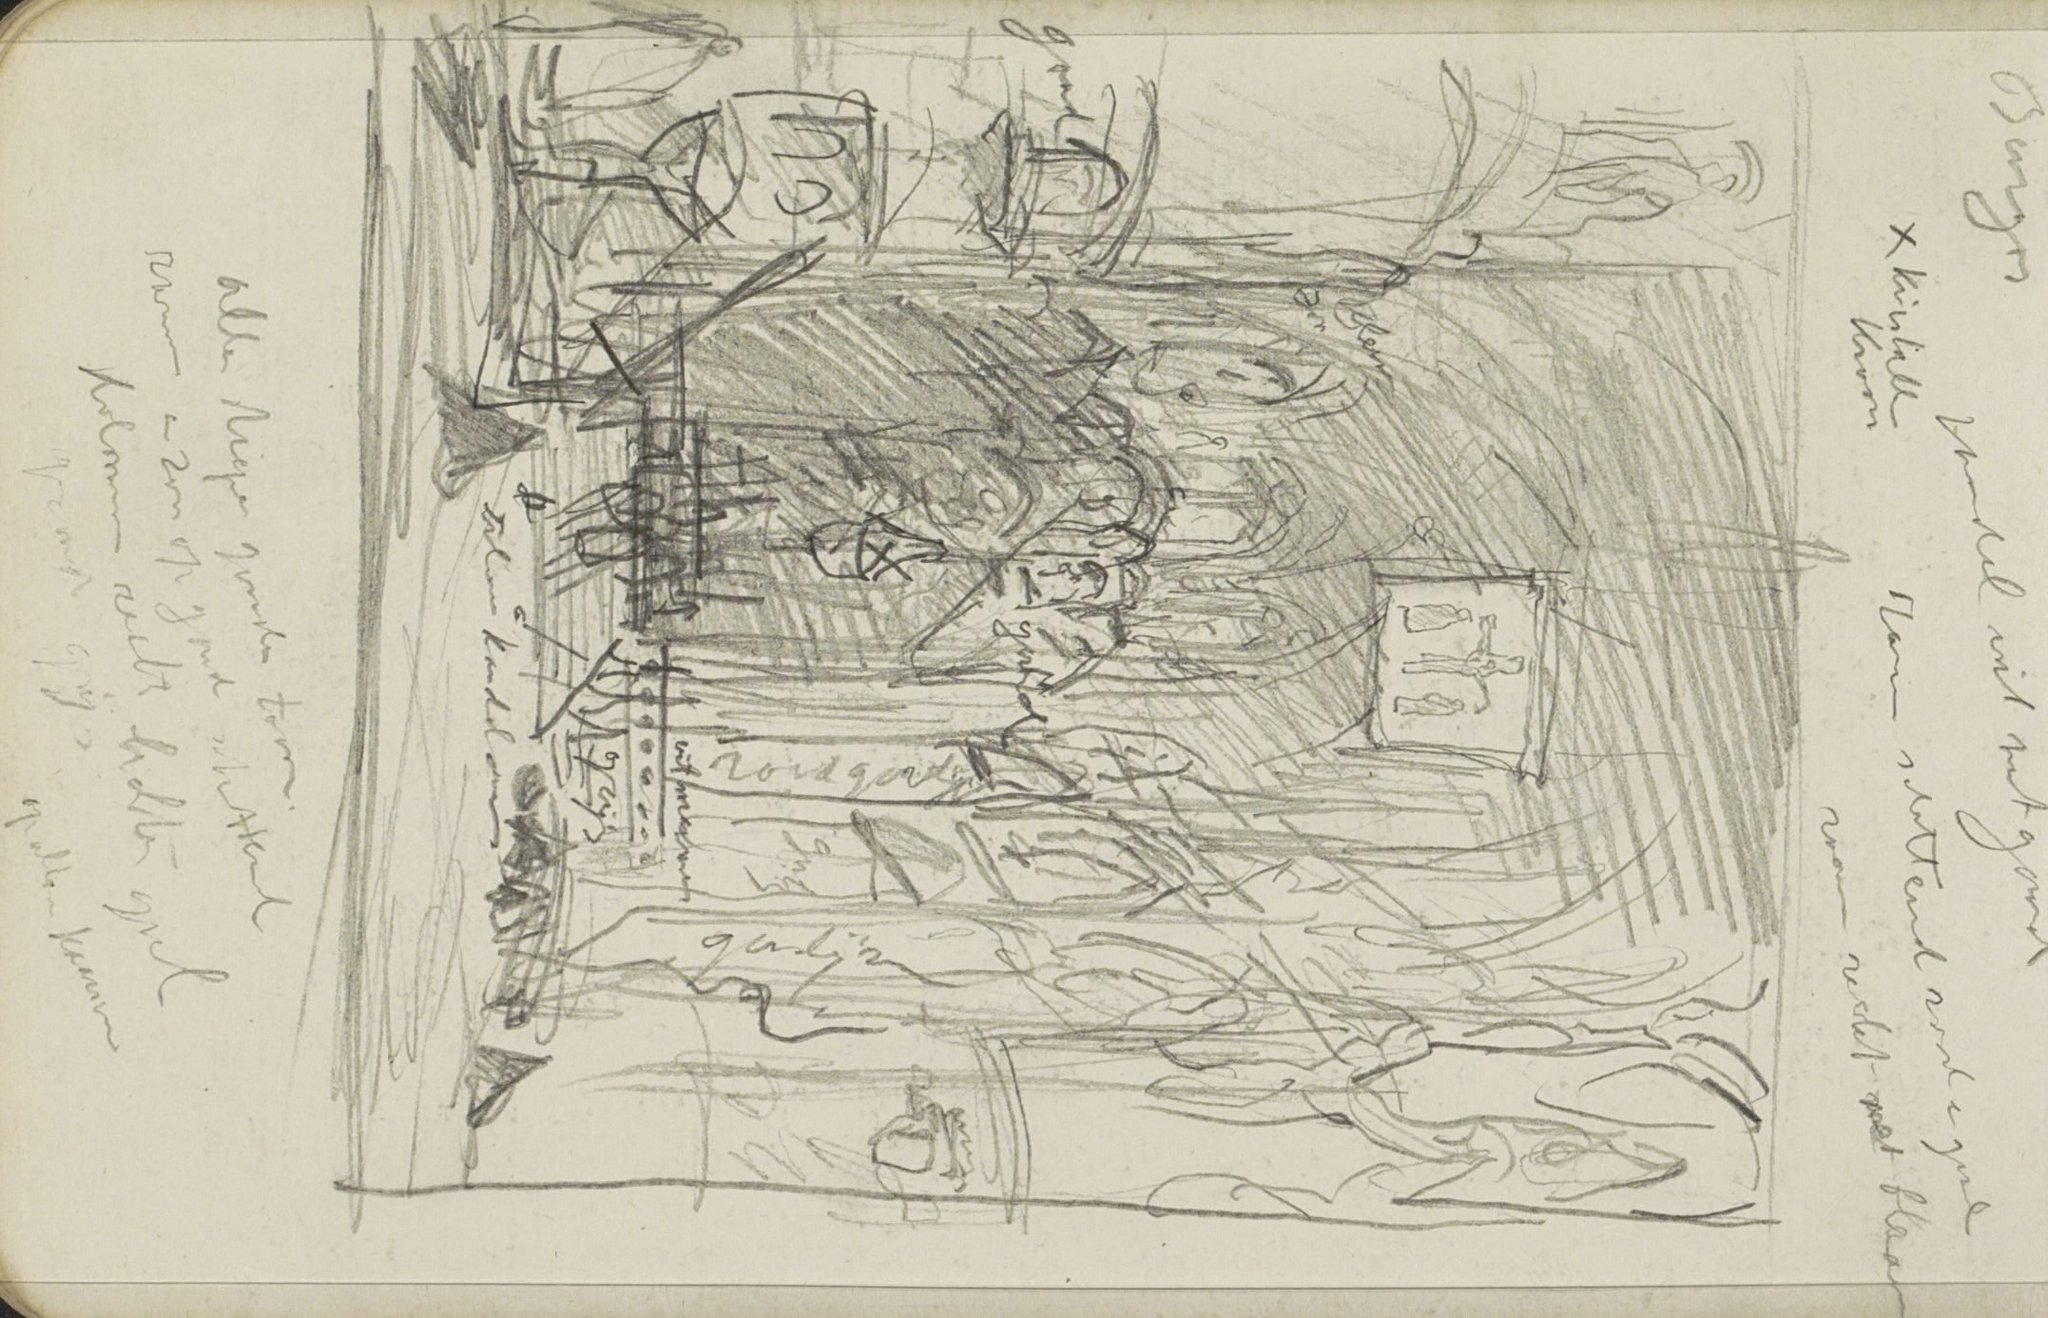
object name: sketchbook leaf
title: Interieur van de kathedraal van Burgos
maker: marius bauer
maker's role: draughtsman, print maker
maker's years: 1867-1932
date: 1902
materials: paper, pencil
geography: burgos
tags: interior of church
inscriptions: annotation: ‘Burgos’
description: Pagina 48 uit een schetsboek met 30 bladen.